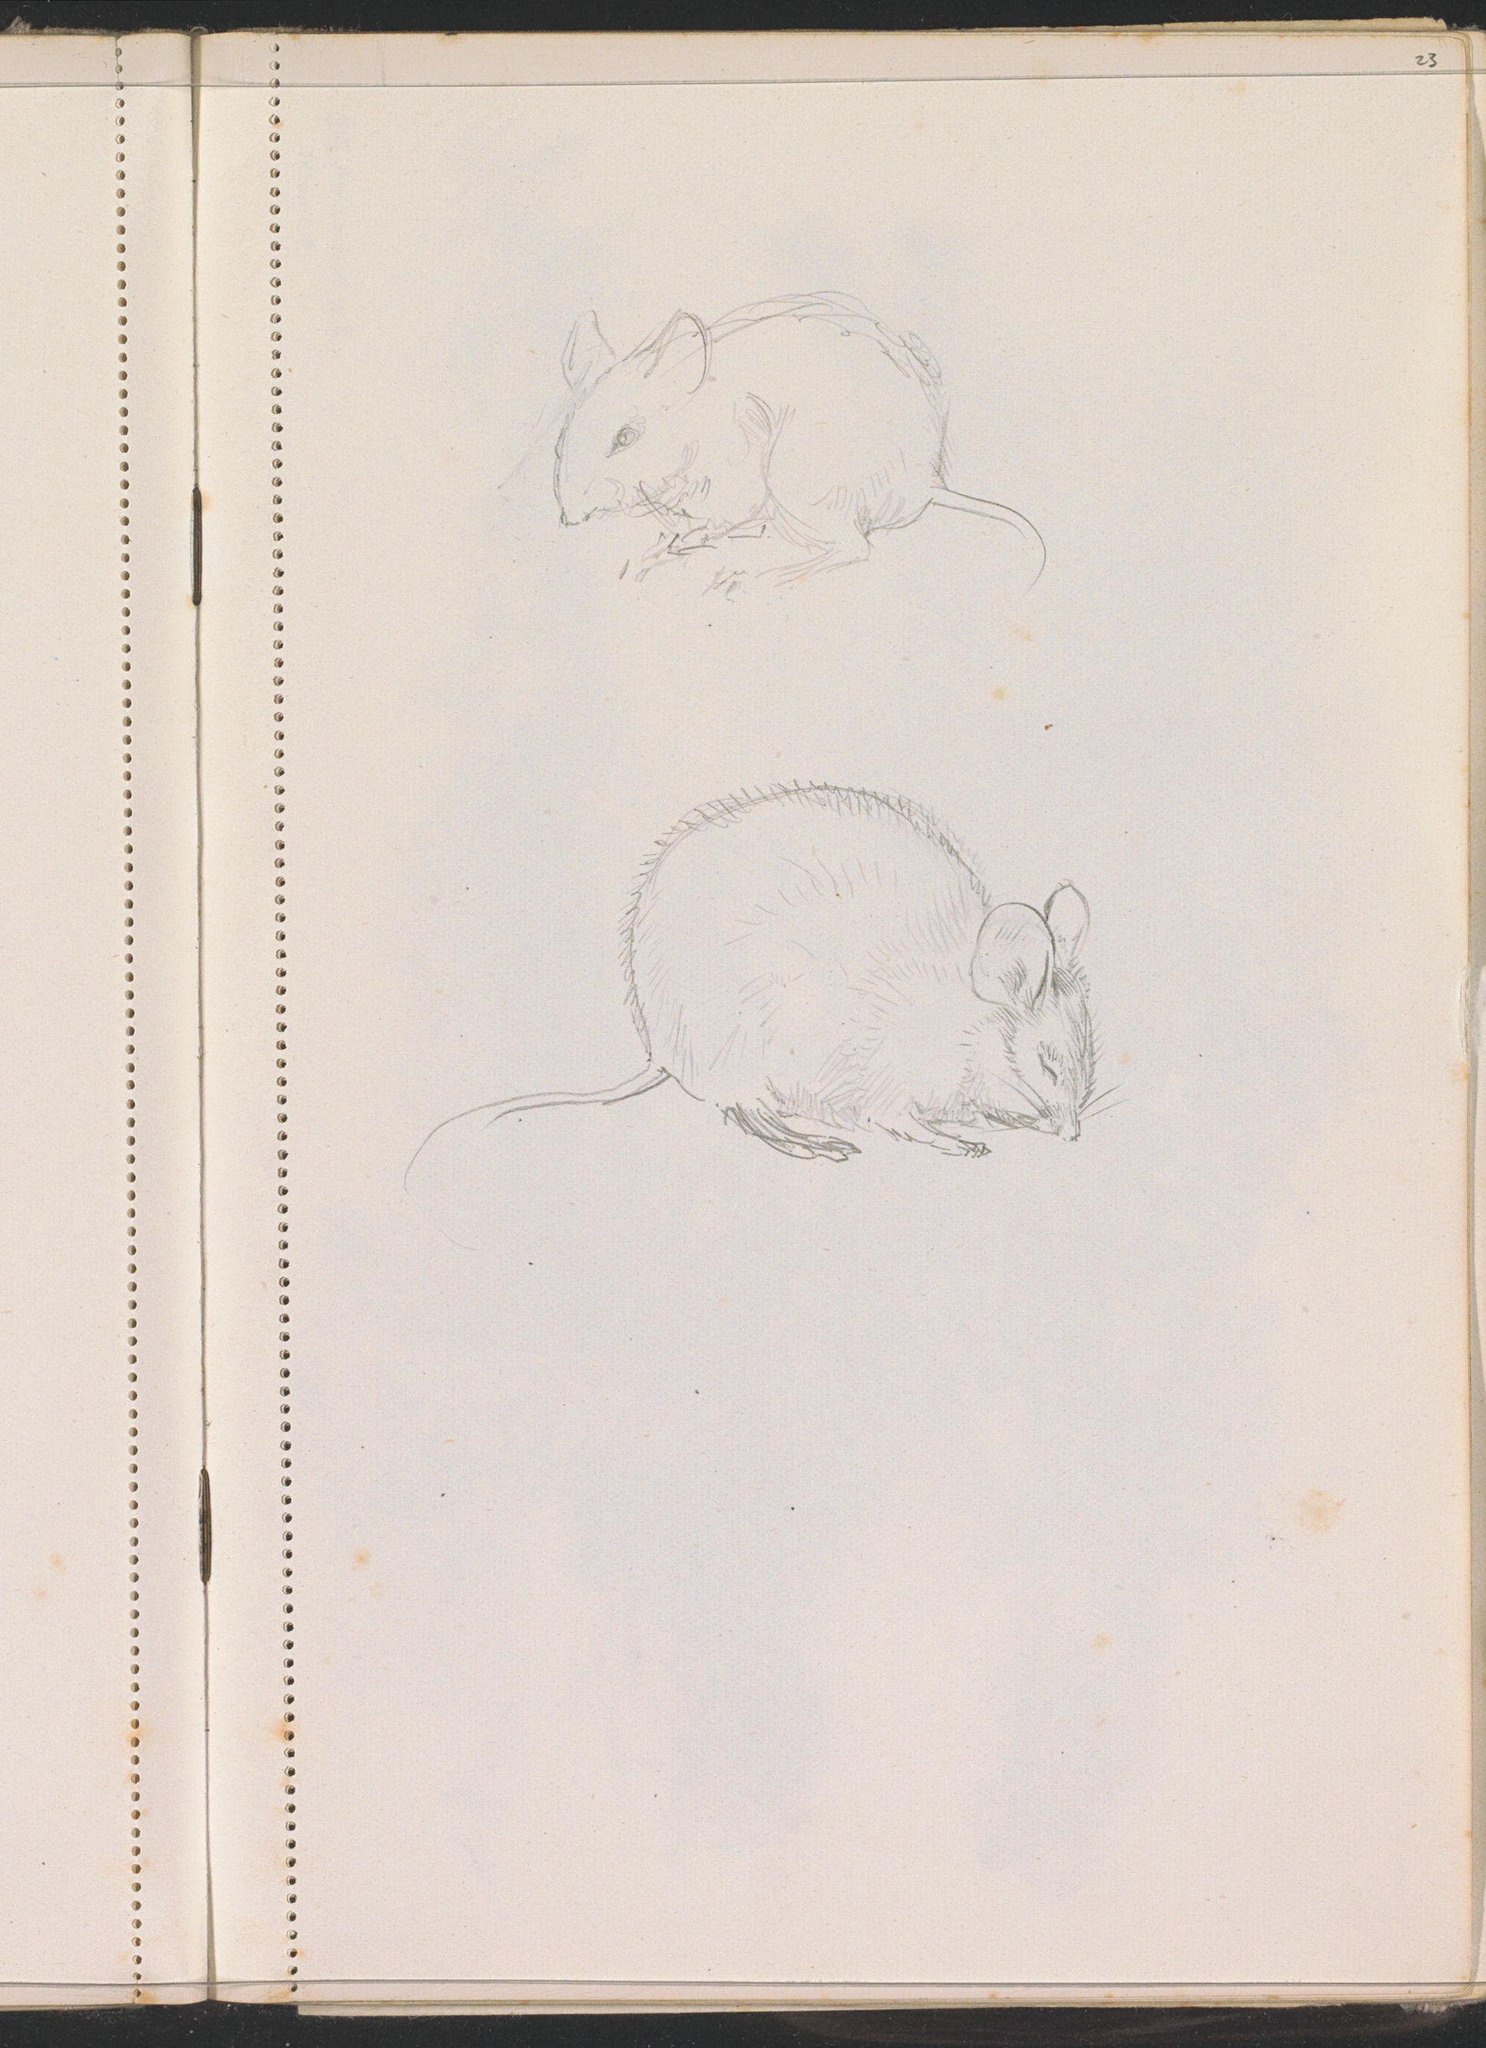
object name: sketchbook leaf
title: Muizen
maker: otto verhagen (i)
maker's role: draughtsman, print maker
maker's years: 1885-1951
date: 1928-1930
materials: paper, pencil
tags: rodents: mouse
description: Pagina 23 uit een schetsboek met 51 bladen.